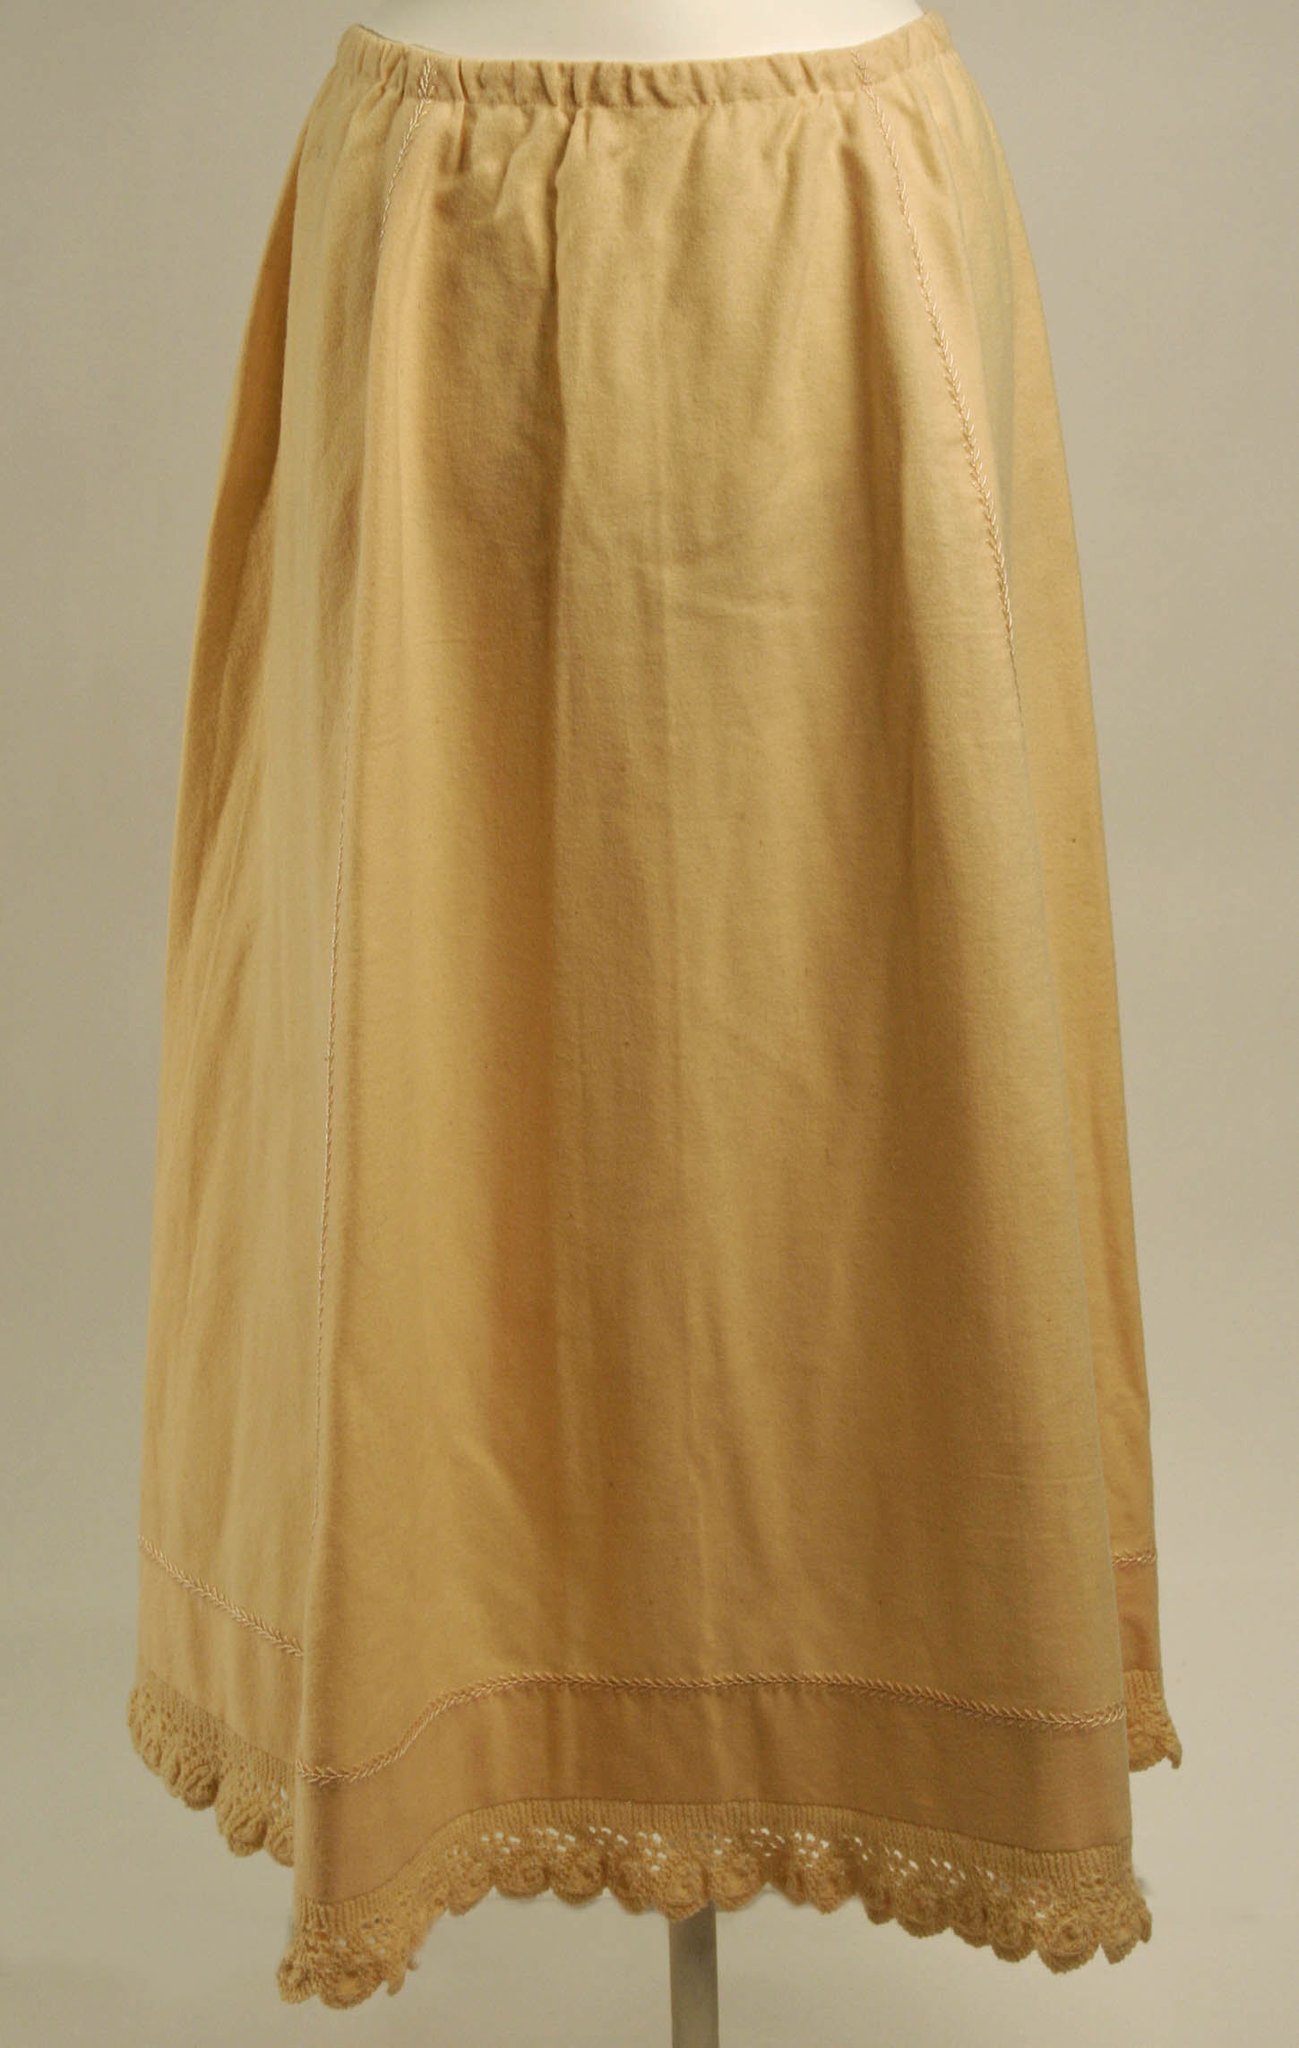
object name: petticoat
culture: american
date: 1880-1889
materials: wool